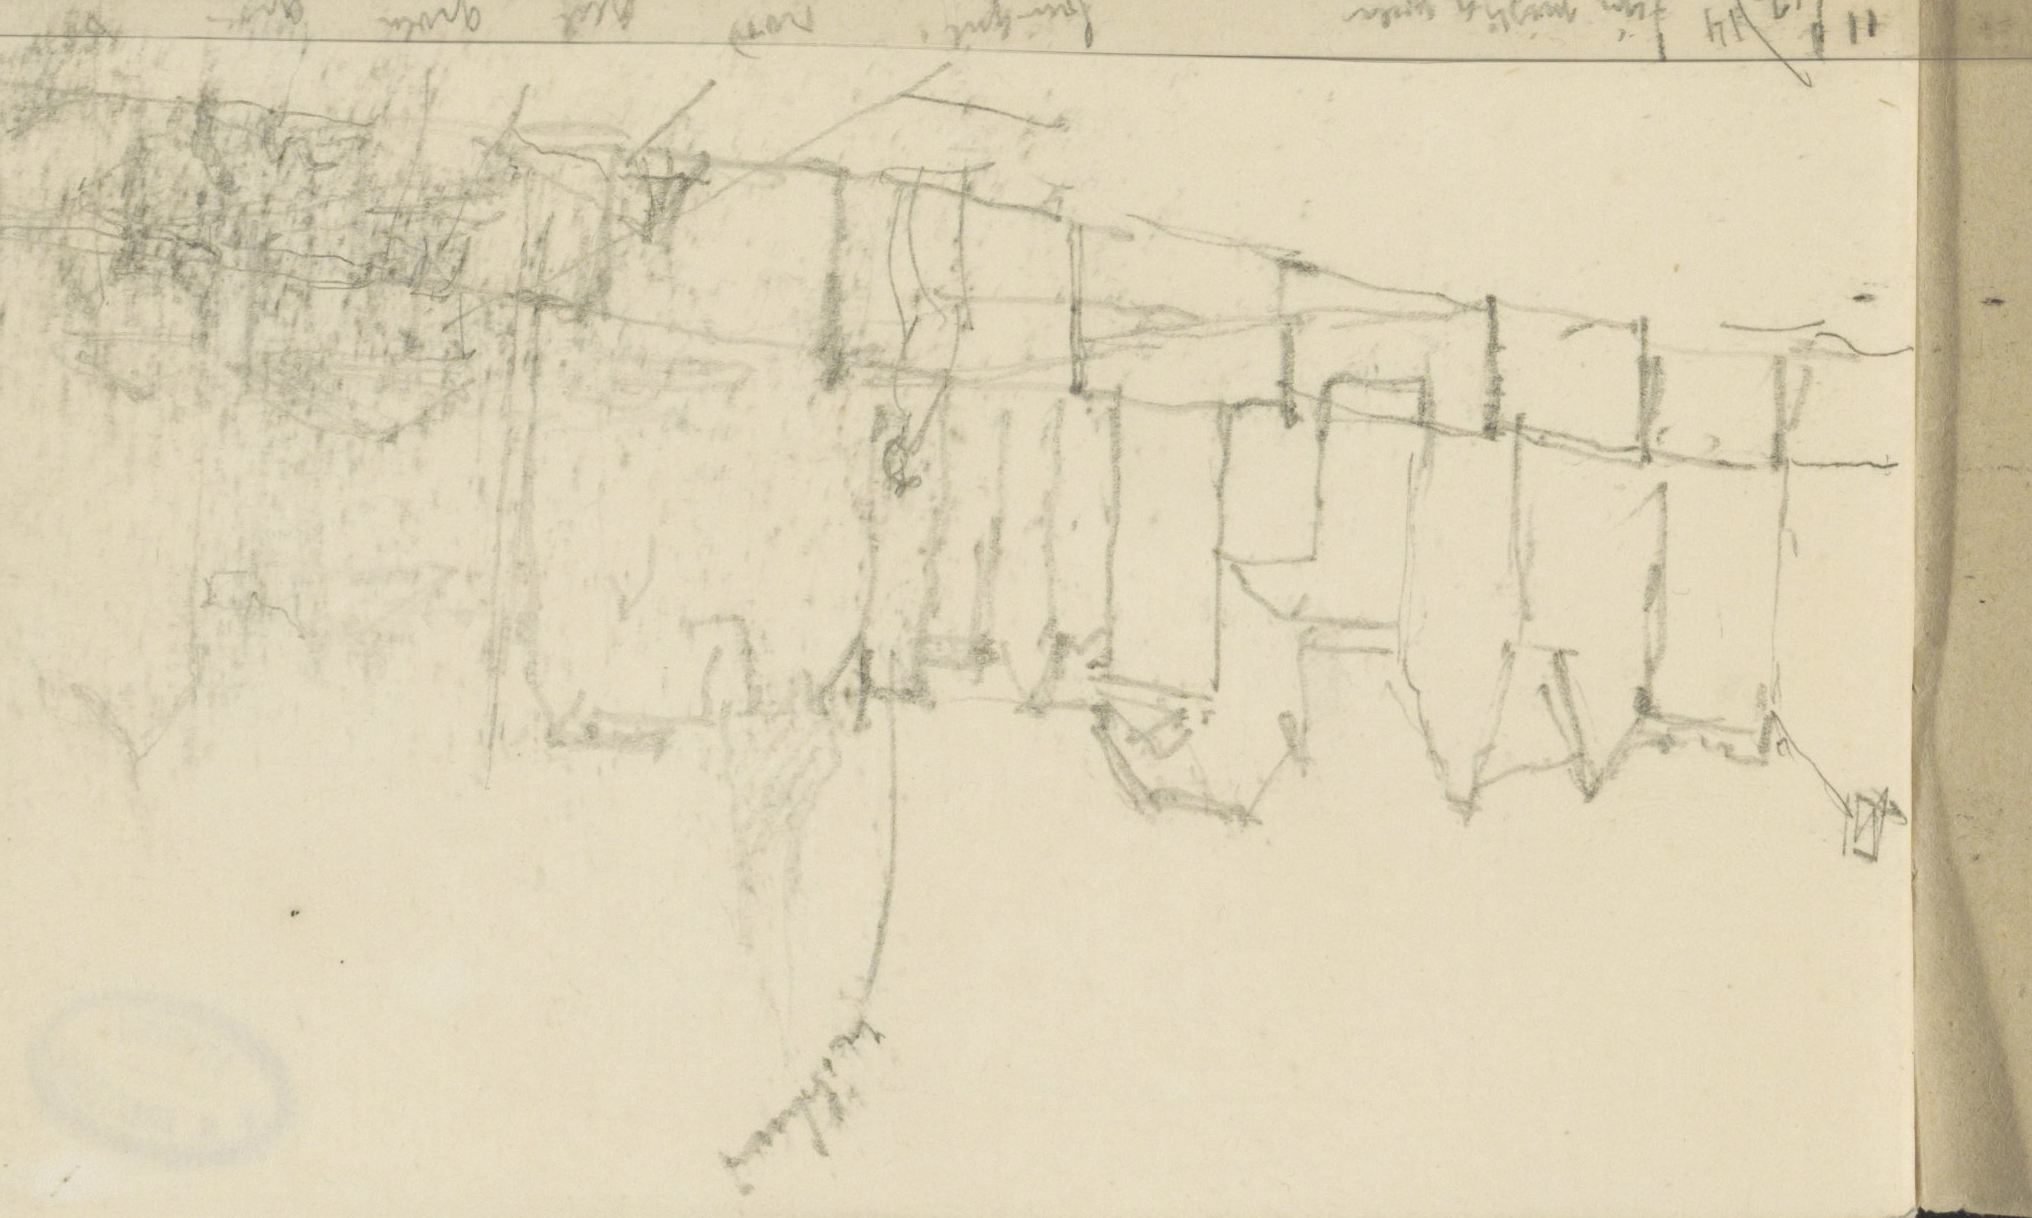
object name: sketchbook leaf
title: Damrak te Amsterdam, gezien vanaf de Nieuwe Brug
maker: george hendrik breitner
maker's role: draughtsman, painter, print maker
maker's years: 1857-1923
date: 1888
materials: paper, pencil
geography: amsterdam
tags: bridge in city across river, canal, etc., civic architecture; edifices; dwellings, parts of church exterior and annexes: tower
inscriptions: annotation: ‘[...] fijn mistig weer’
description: Met de achterzijde van de gebouwen aan de Warmoesstraat en de toren van de Oude Kerk. Pagina 49 uit een schetsboek met 24 bladen.